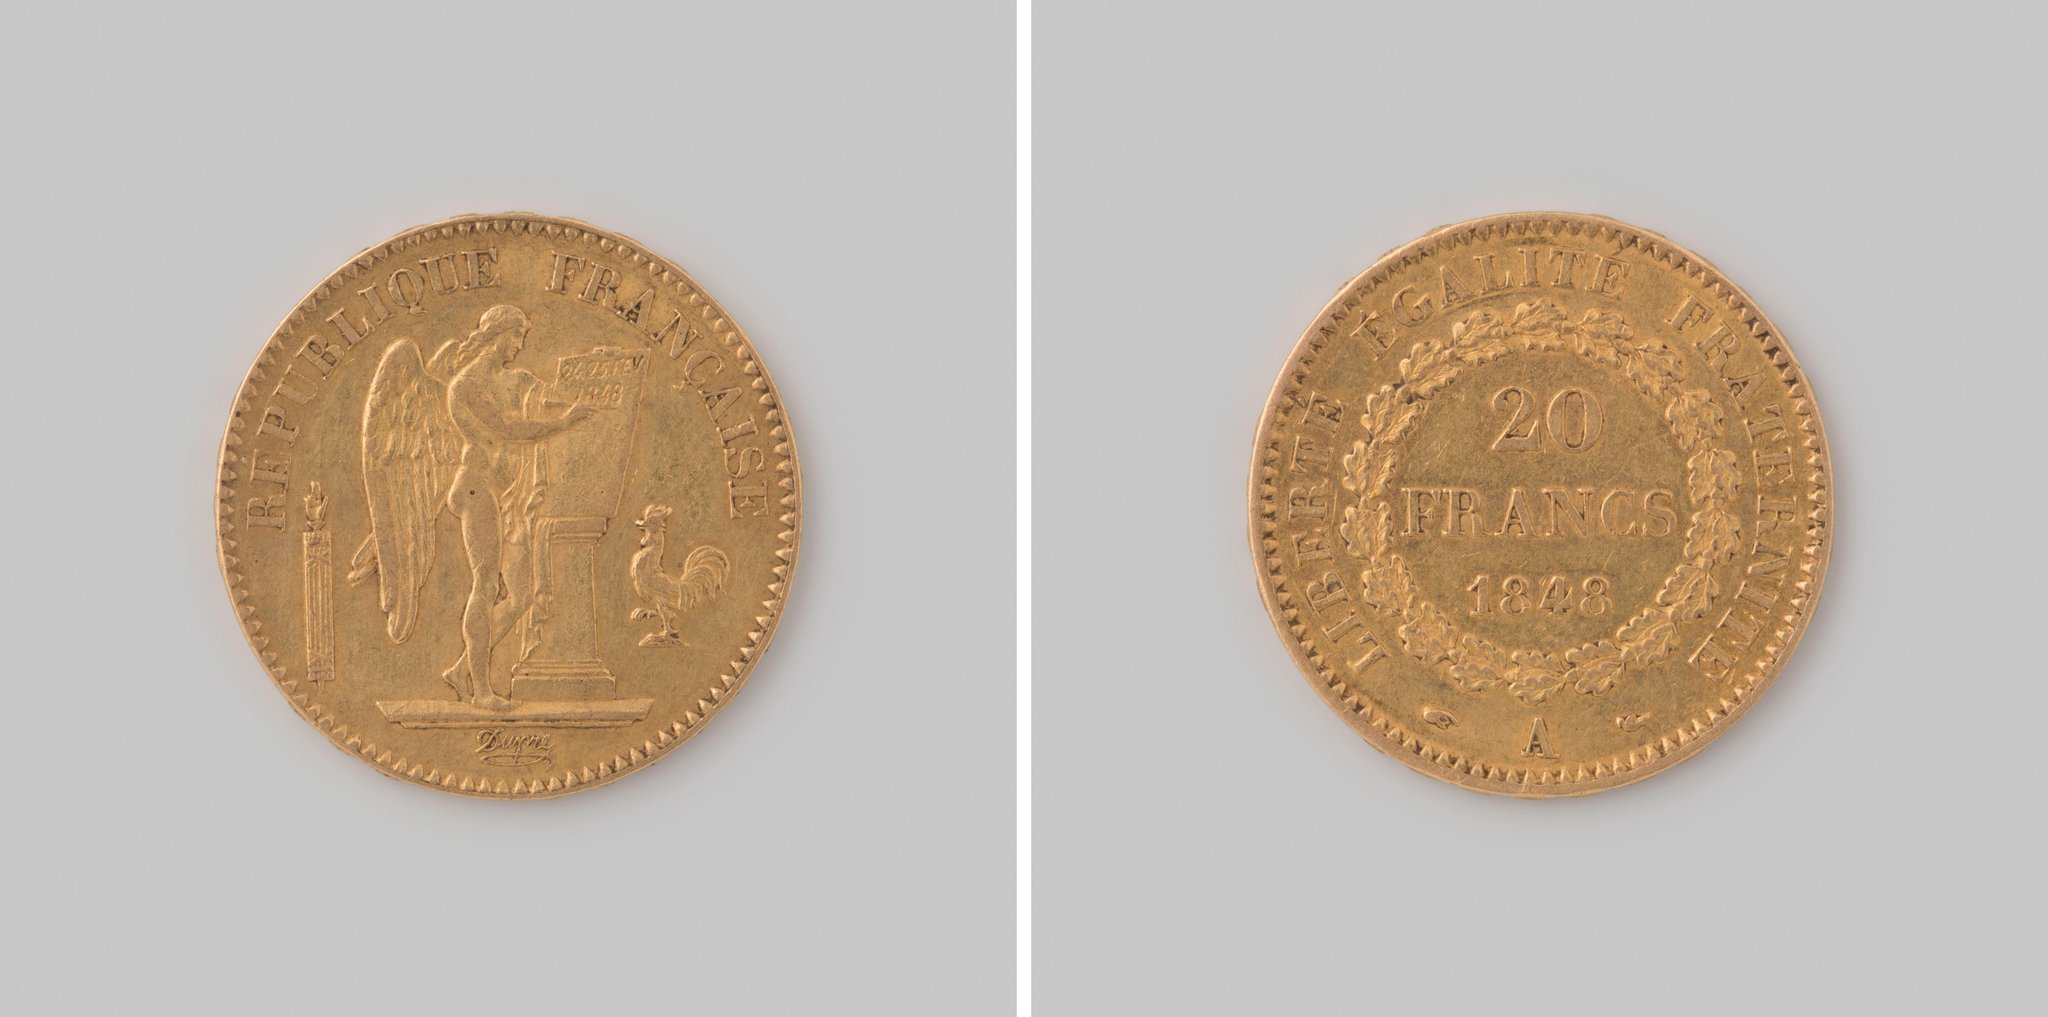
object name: twintig franc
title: Frankrijk, Tweede Republiek, 20 francs,1848 A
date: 1848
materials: gold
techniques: striking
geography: paris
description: Gouden munt. Voorzijde: gevleugelde jongeling naar rechts die op een op voetstuk staand bord in twee regels schrijft: 24/25 fev. 1848. Links en rechts van hem attributen. Keerzijde: binnen een krans van eikenbladeren waarde-aanduiding in twee regels, waaronder jaartal. Onderaan de letter A [=Parijs]. Opliggend randschrift.